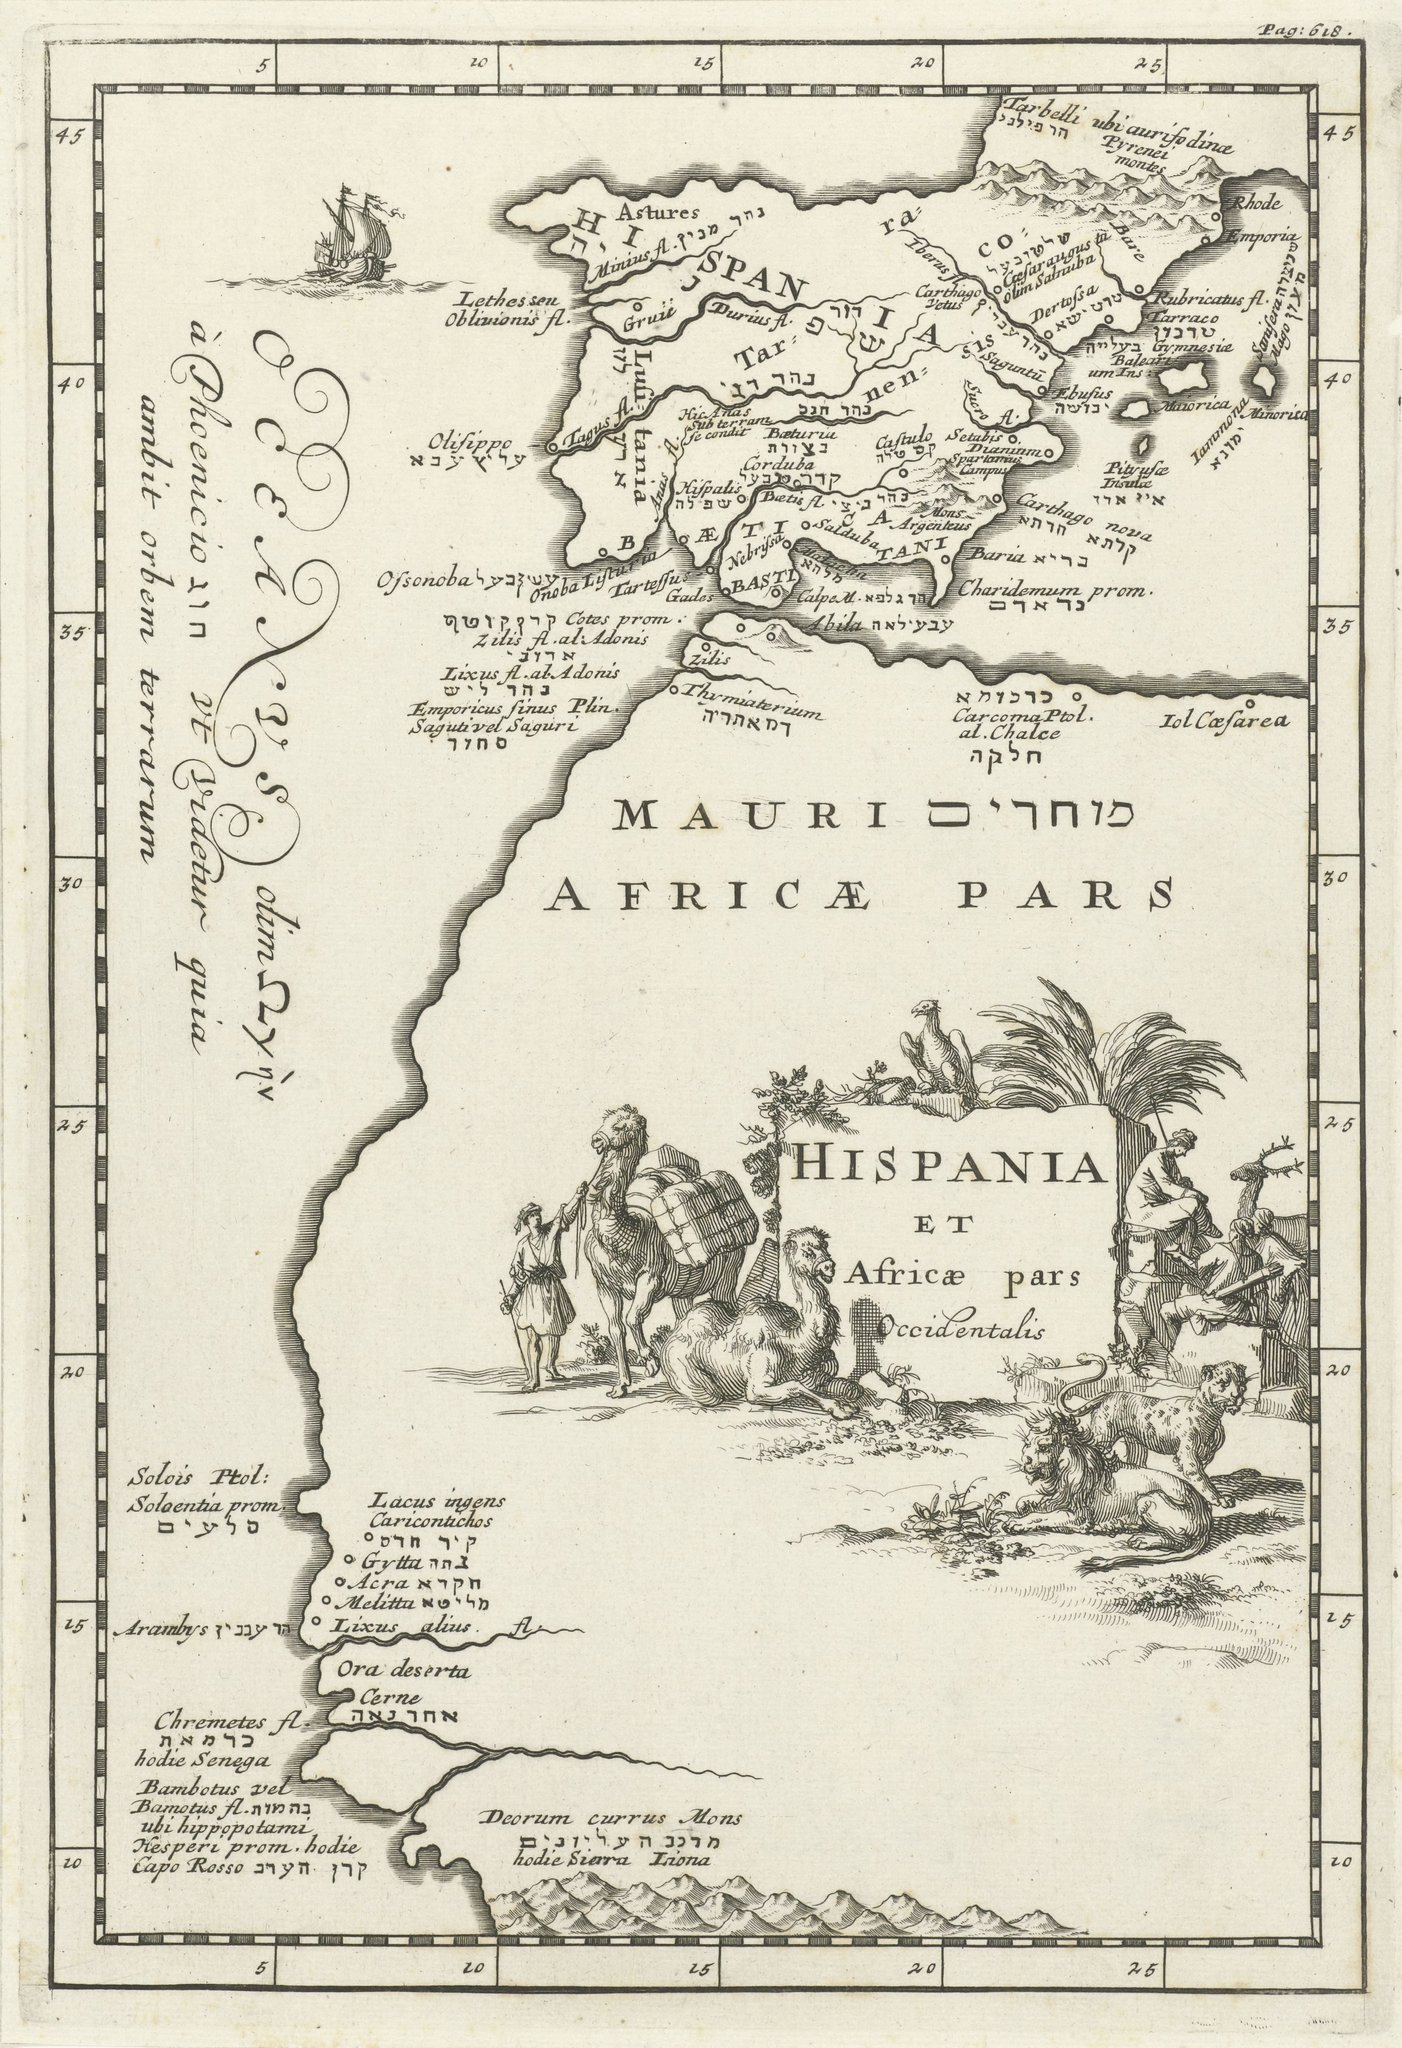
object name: book illustration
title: Hispania et Africae Pars Occidentalis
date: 1692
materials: paper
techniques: etching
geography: leiden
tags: maps of separate countries or regions, spain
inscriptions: collector's mark: Lugt 2228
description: Illustratie uit: Bochart, Samuel. Opera Omnia (...). Editio tertia, 2 delen. Leiden: Cornelis Boutesteyn en Jordaan Luchtmans, 1692, dl. I.